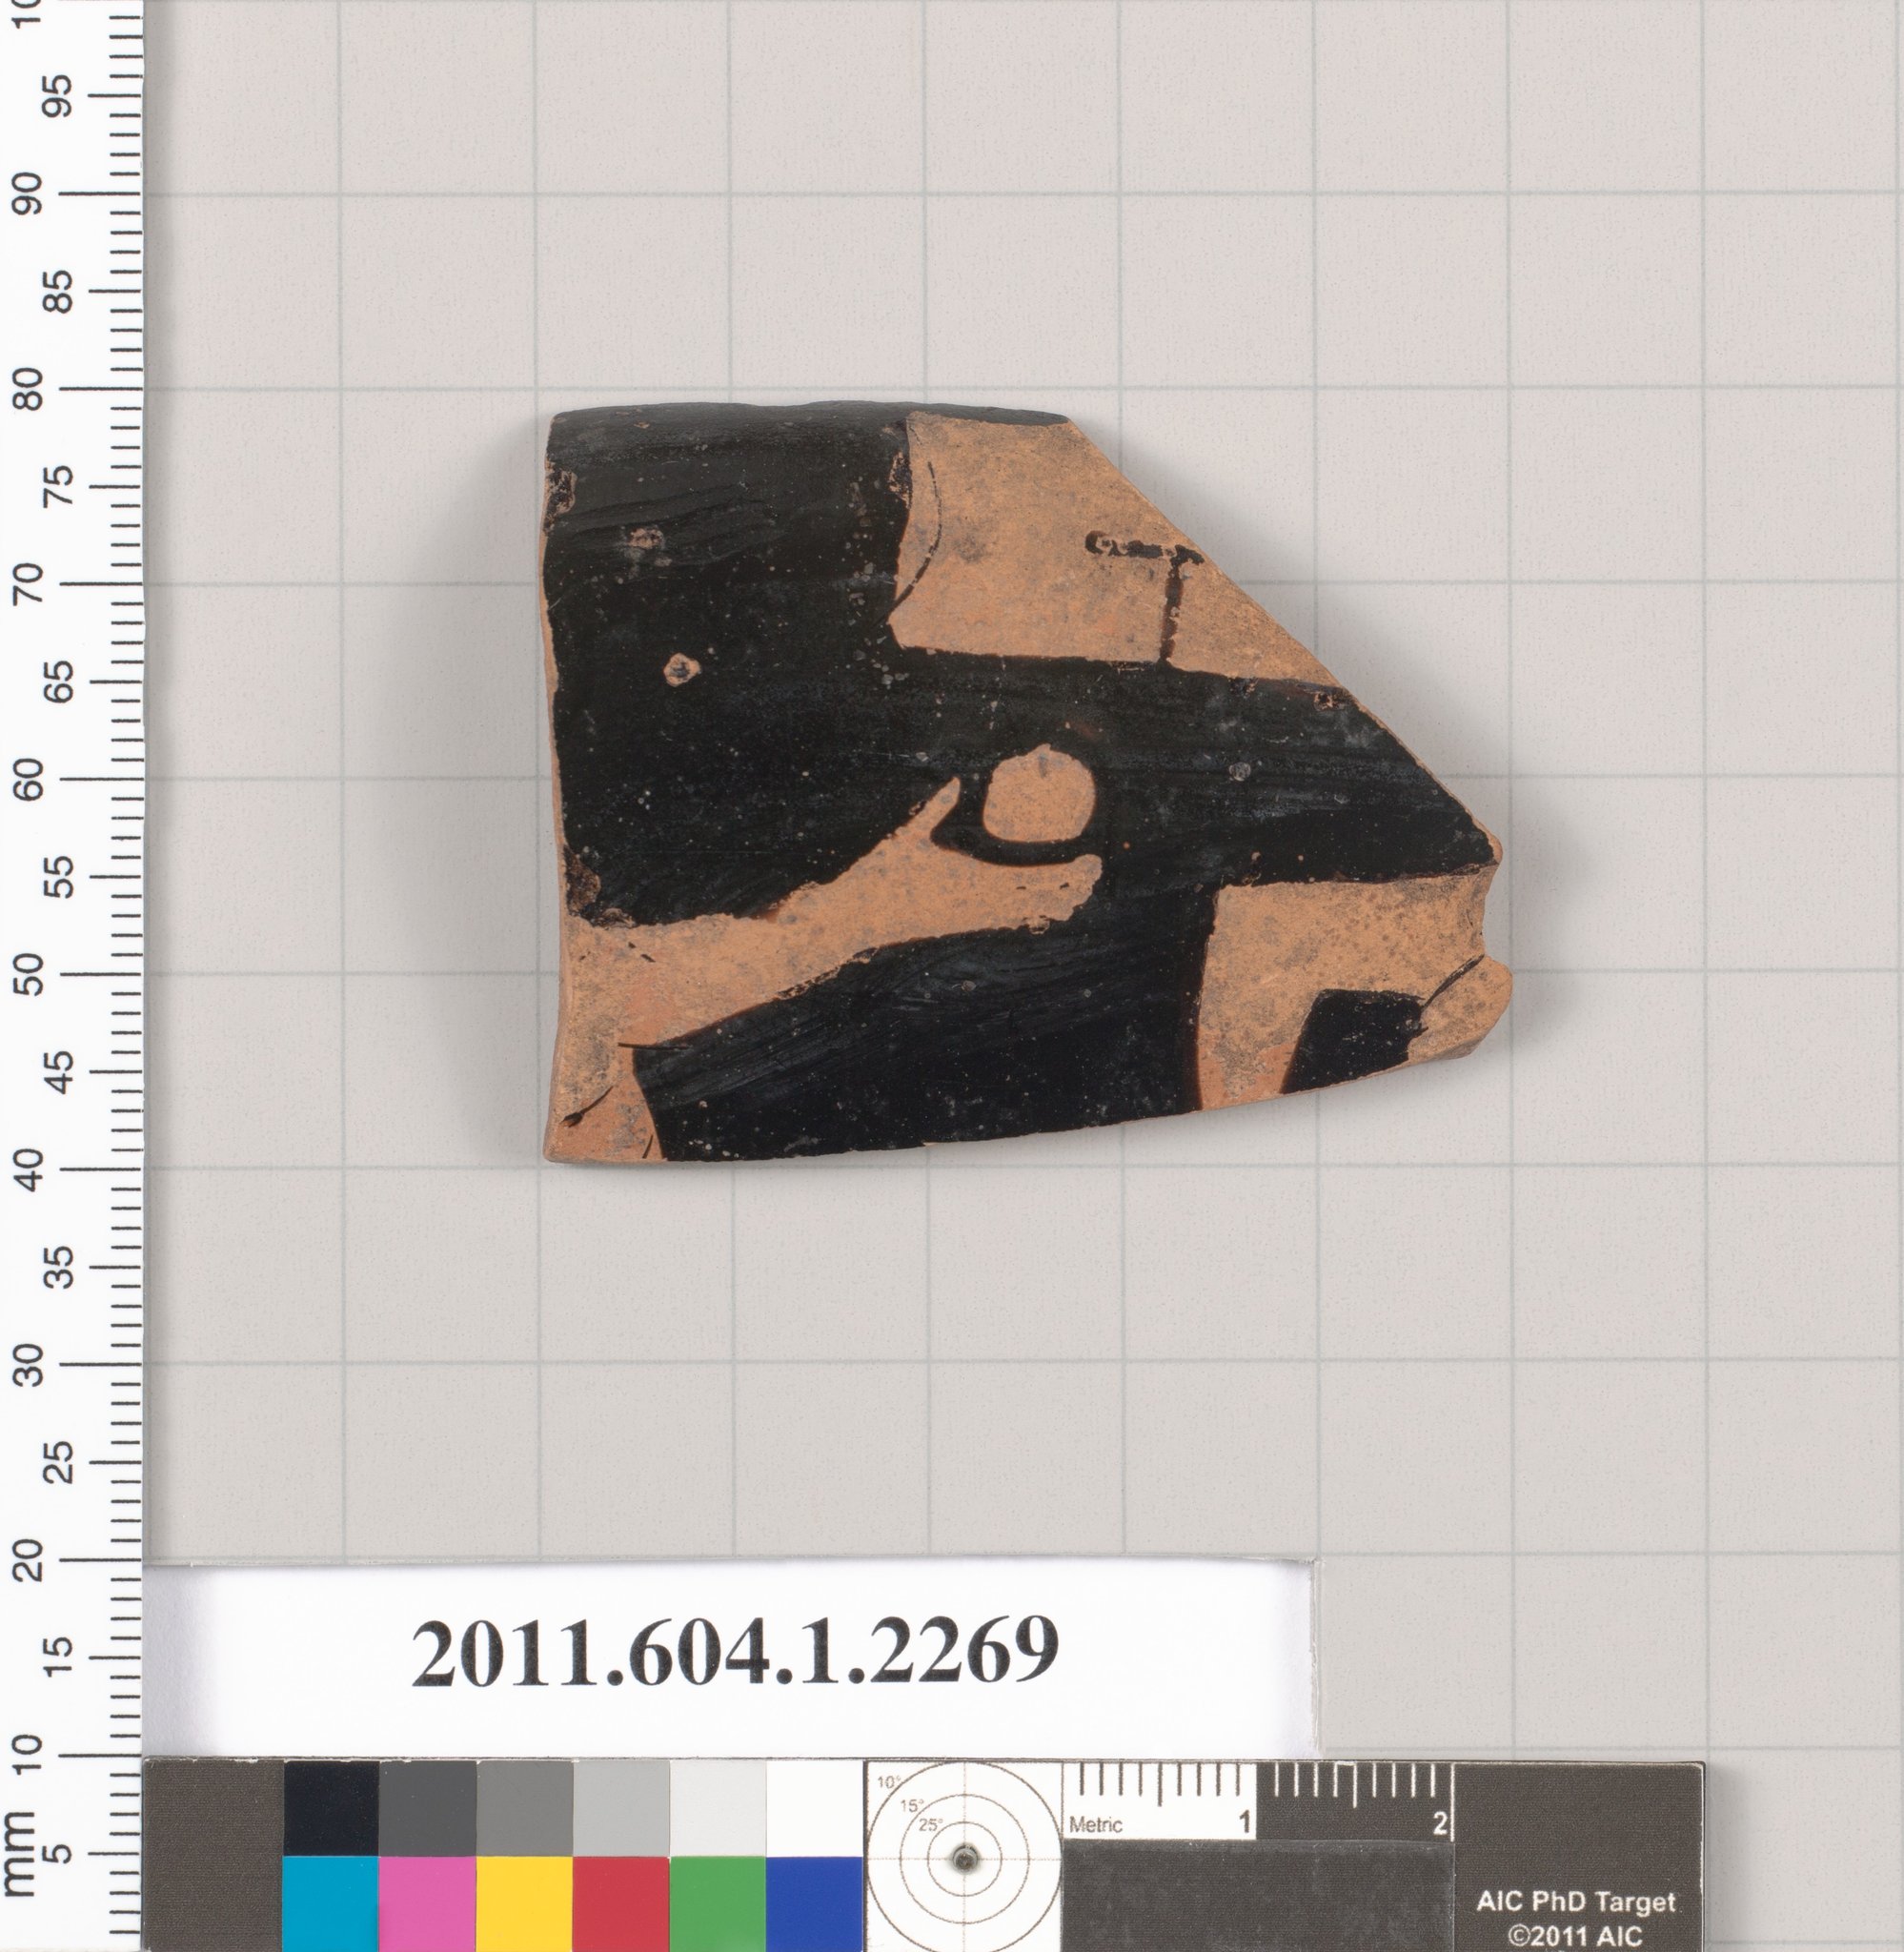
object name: kylix fragment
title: Terracotta rim fragment of a kylix (drinking cup)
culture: greek, attic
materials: terracotta